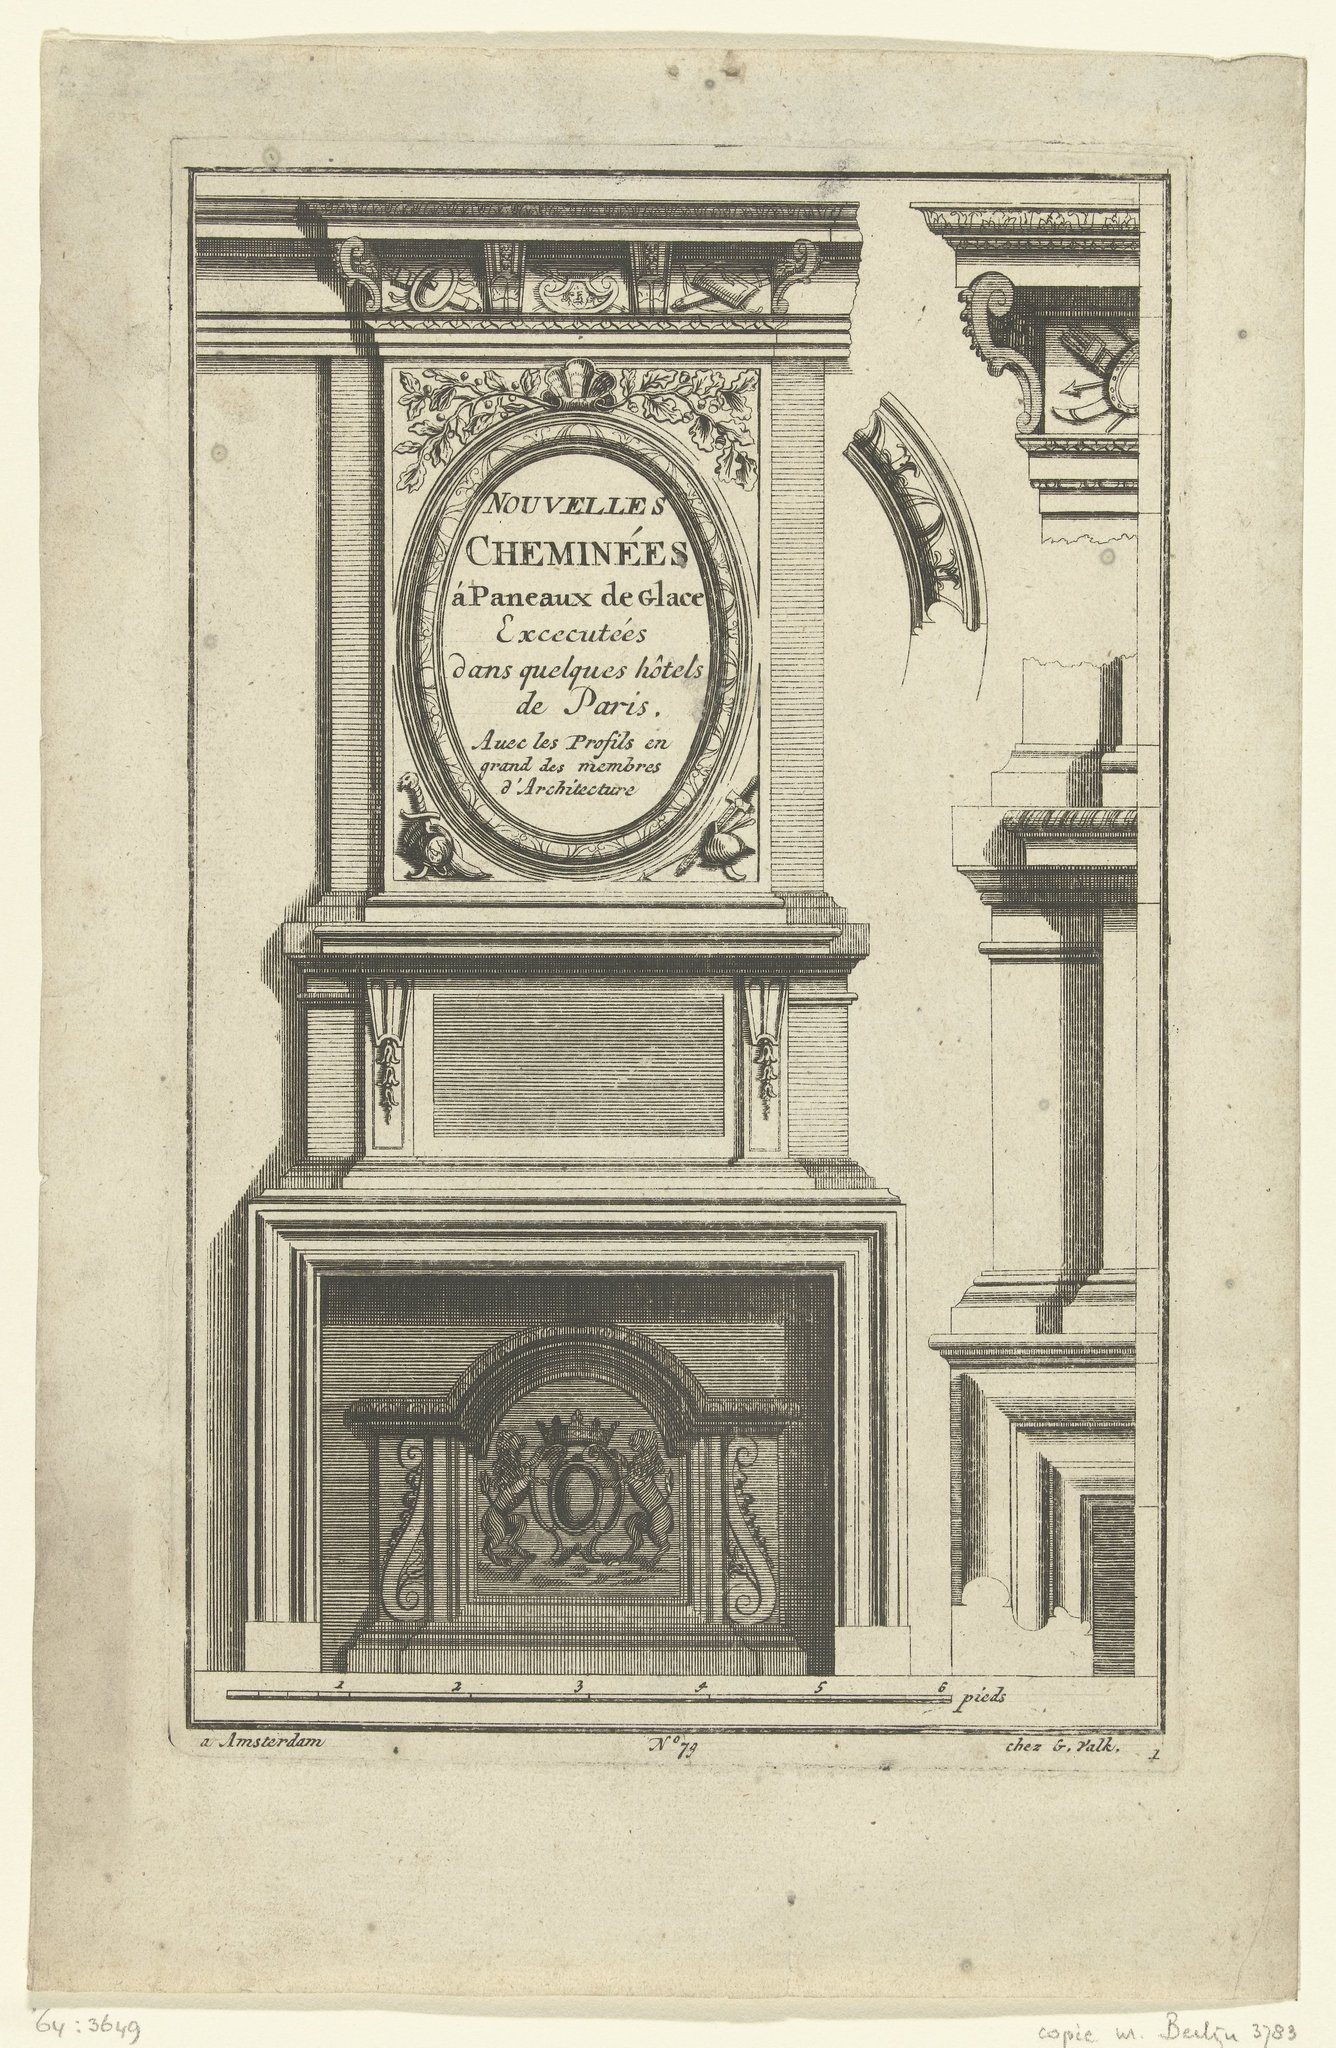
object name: print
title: Nouvelles cheminées à paneaux de glace exécuté dans quelques hôtels à Paris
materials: paper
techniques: etching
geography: netherlands